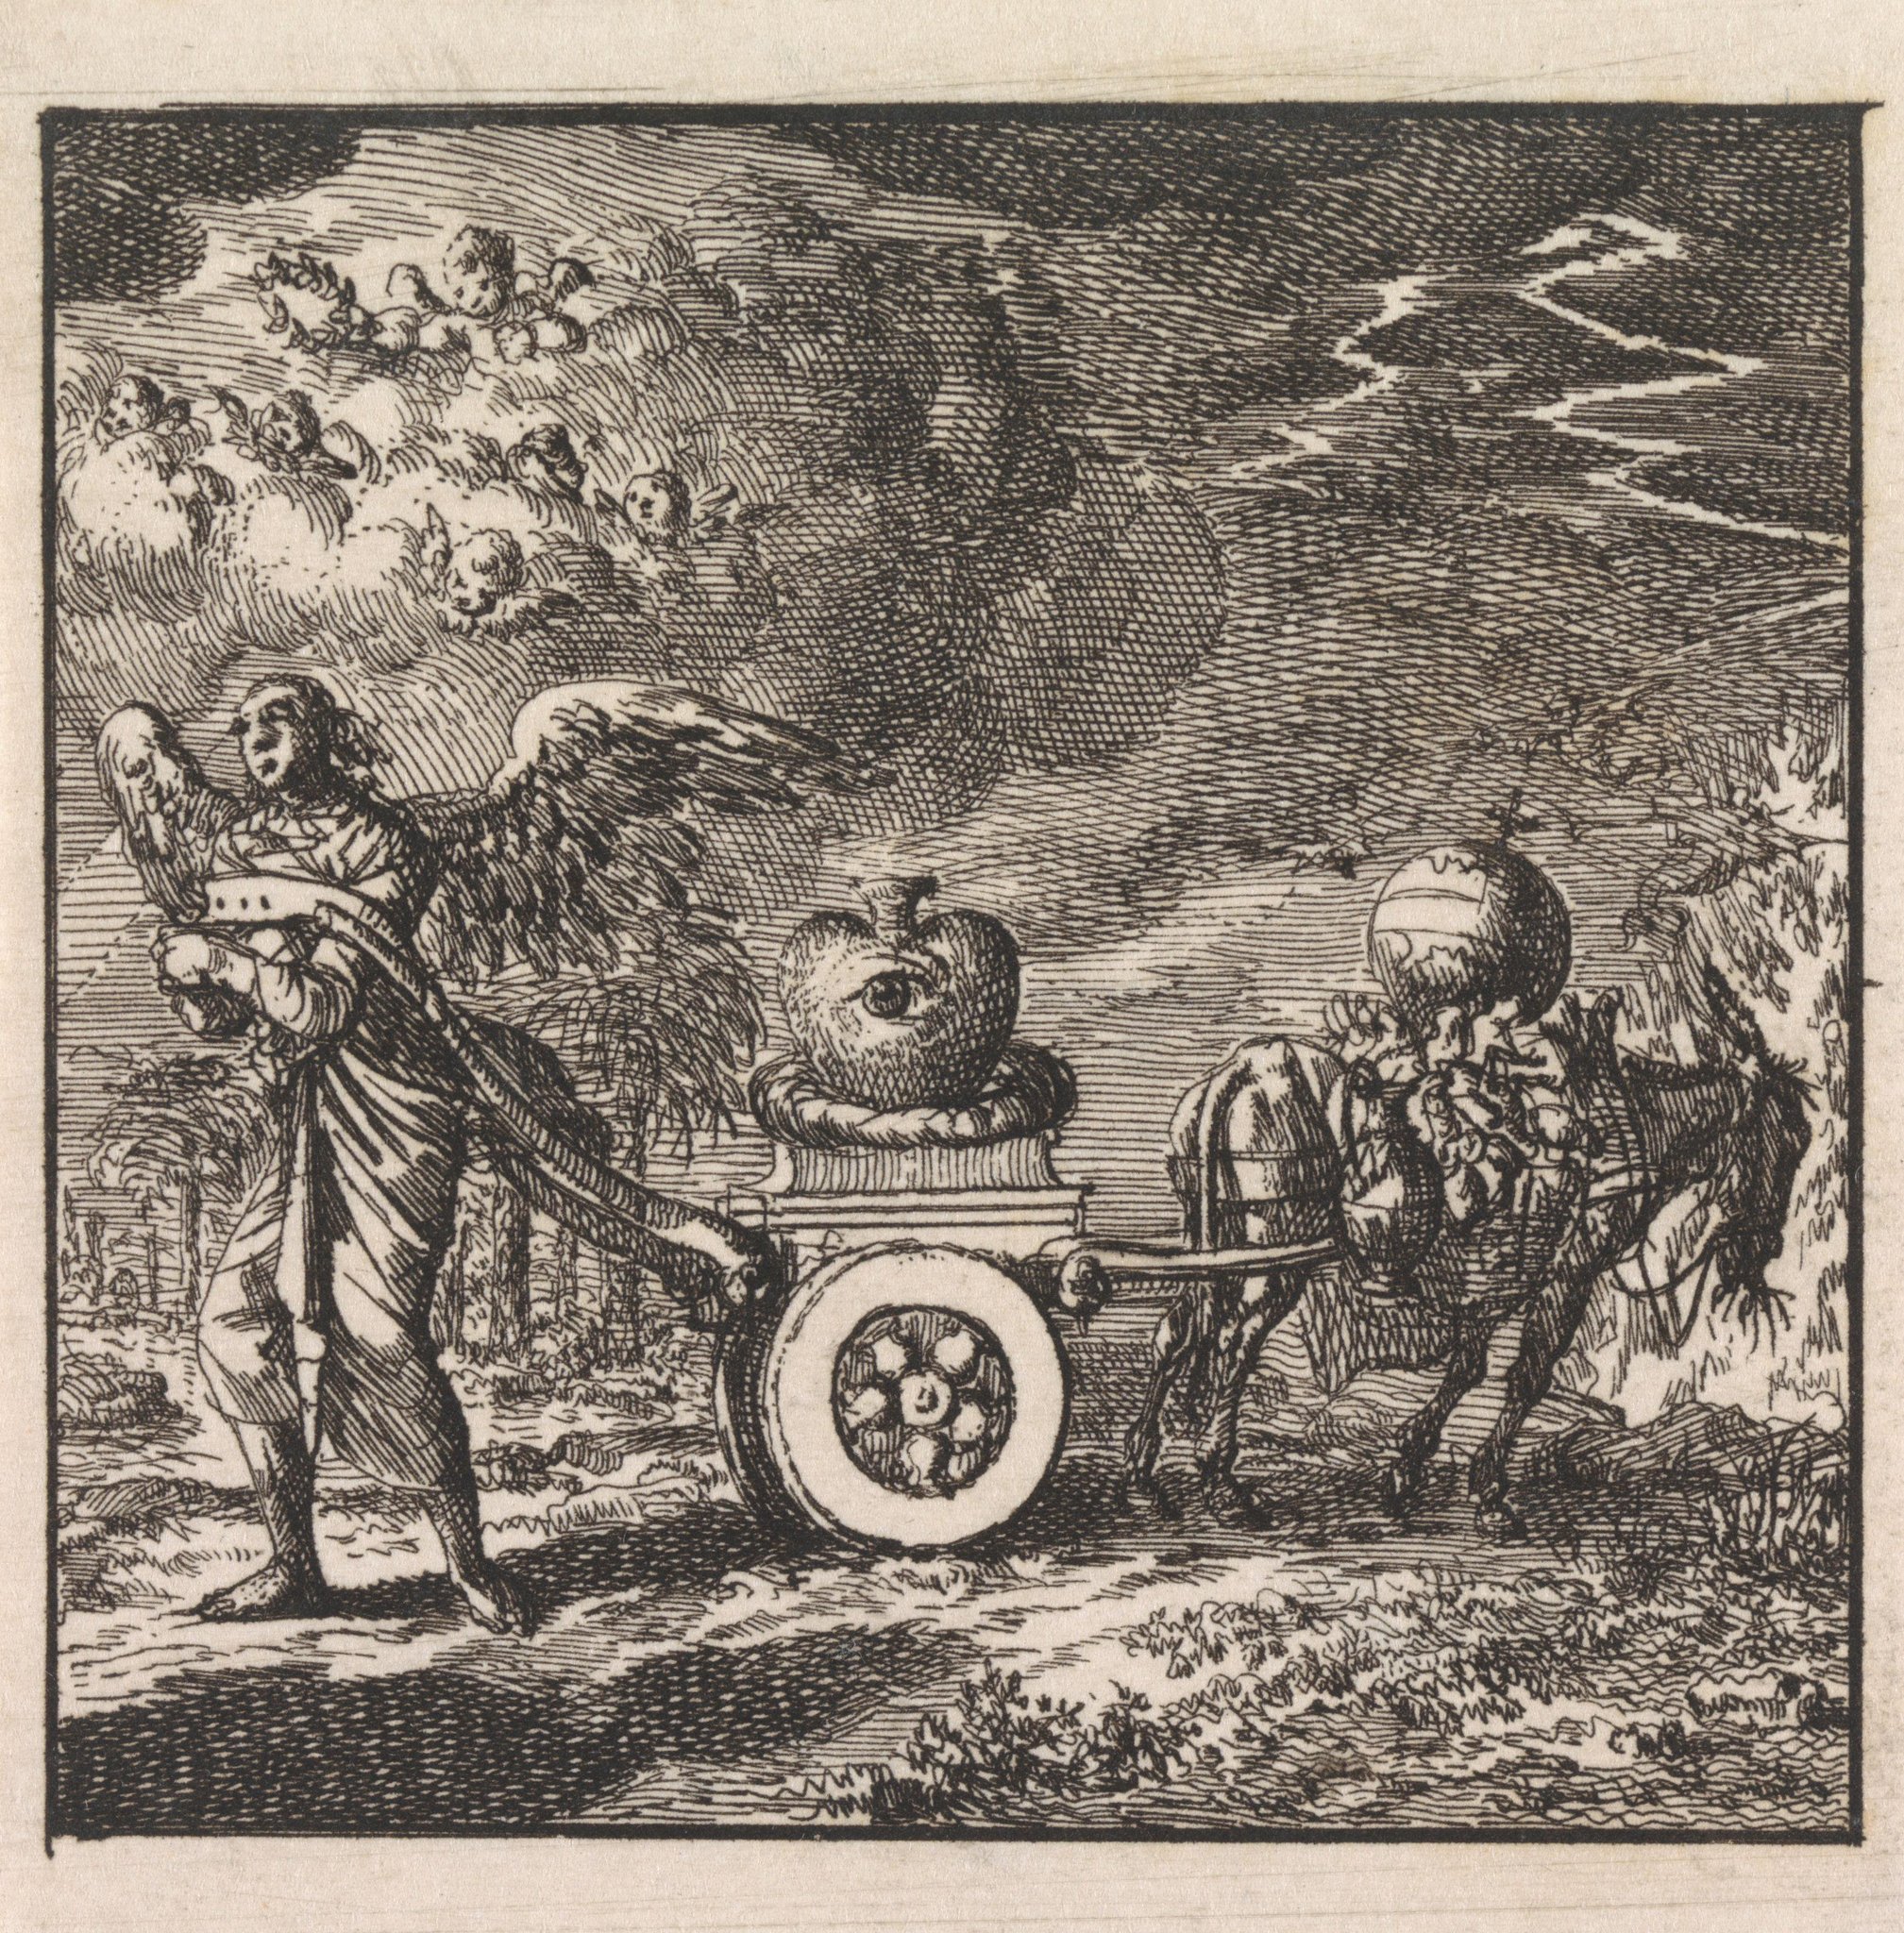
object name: print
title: De Herten Wagen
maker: jan luyken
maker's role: draughtsman, print maker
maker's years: 1649-1712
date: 1710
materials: paper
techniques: etching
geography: amsterdam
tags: thunder, two-wheeled vehicle drawn by one animal (+ variant), heart symbolism, angels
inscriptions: collector's mark: Lugt 2228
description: Proefdruk voor illustratie uit: Luyken, Jan. De onwaardige wereld, vertoond in vyftig zinnebeelden, met godlyke spreuken en stichtelyke verzen. Amsterdam: Pieter Arentsz. II (wed.) en Cornelis van der Sys, 1710, p. 112.